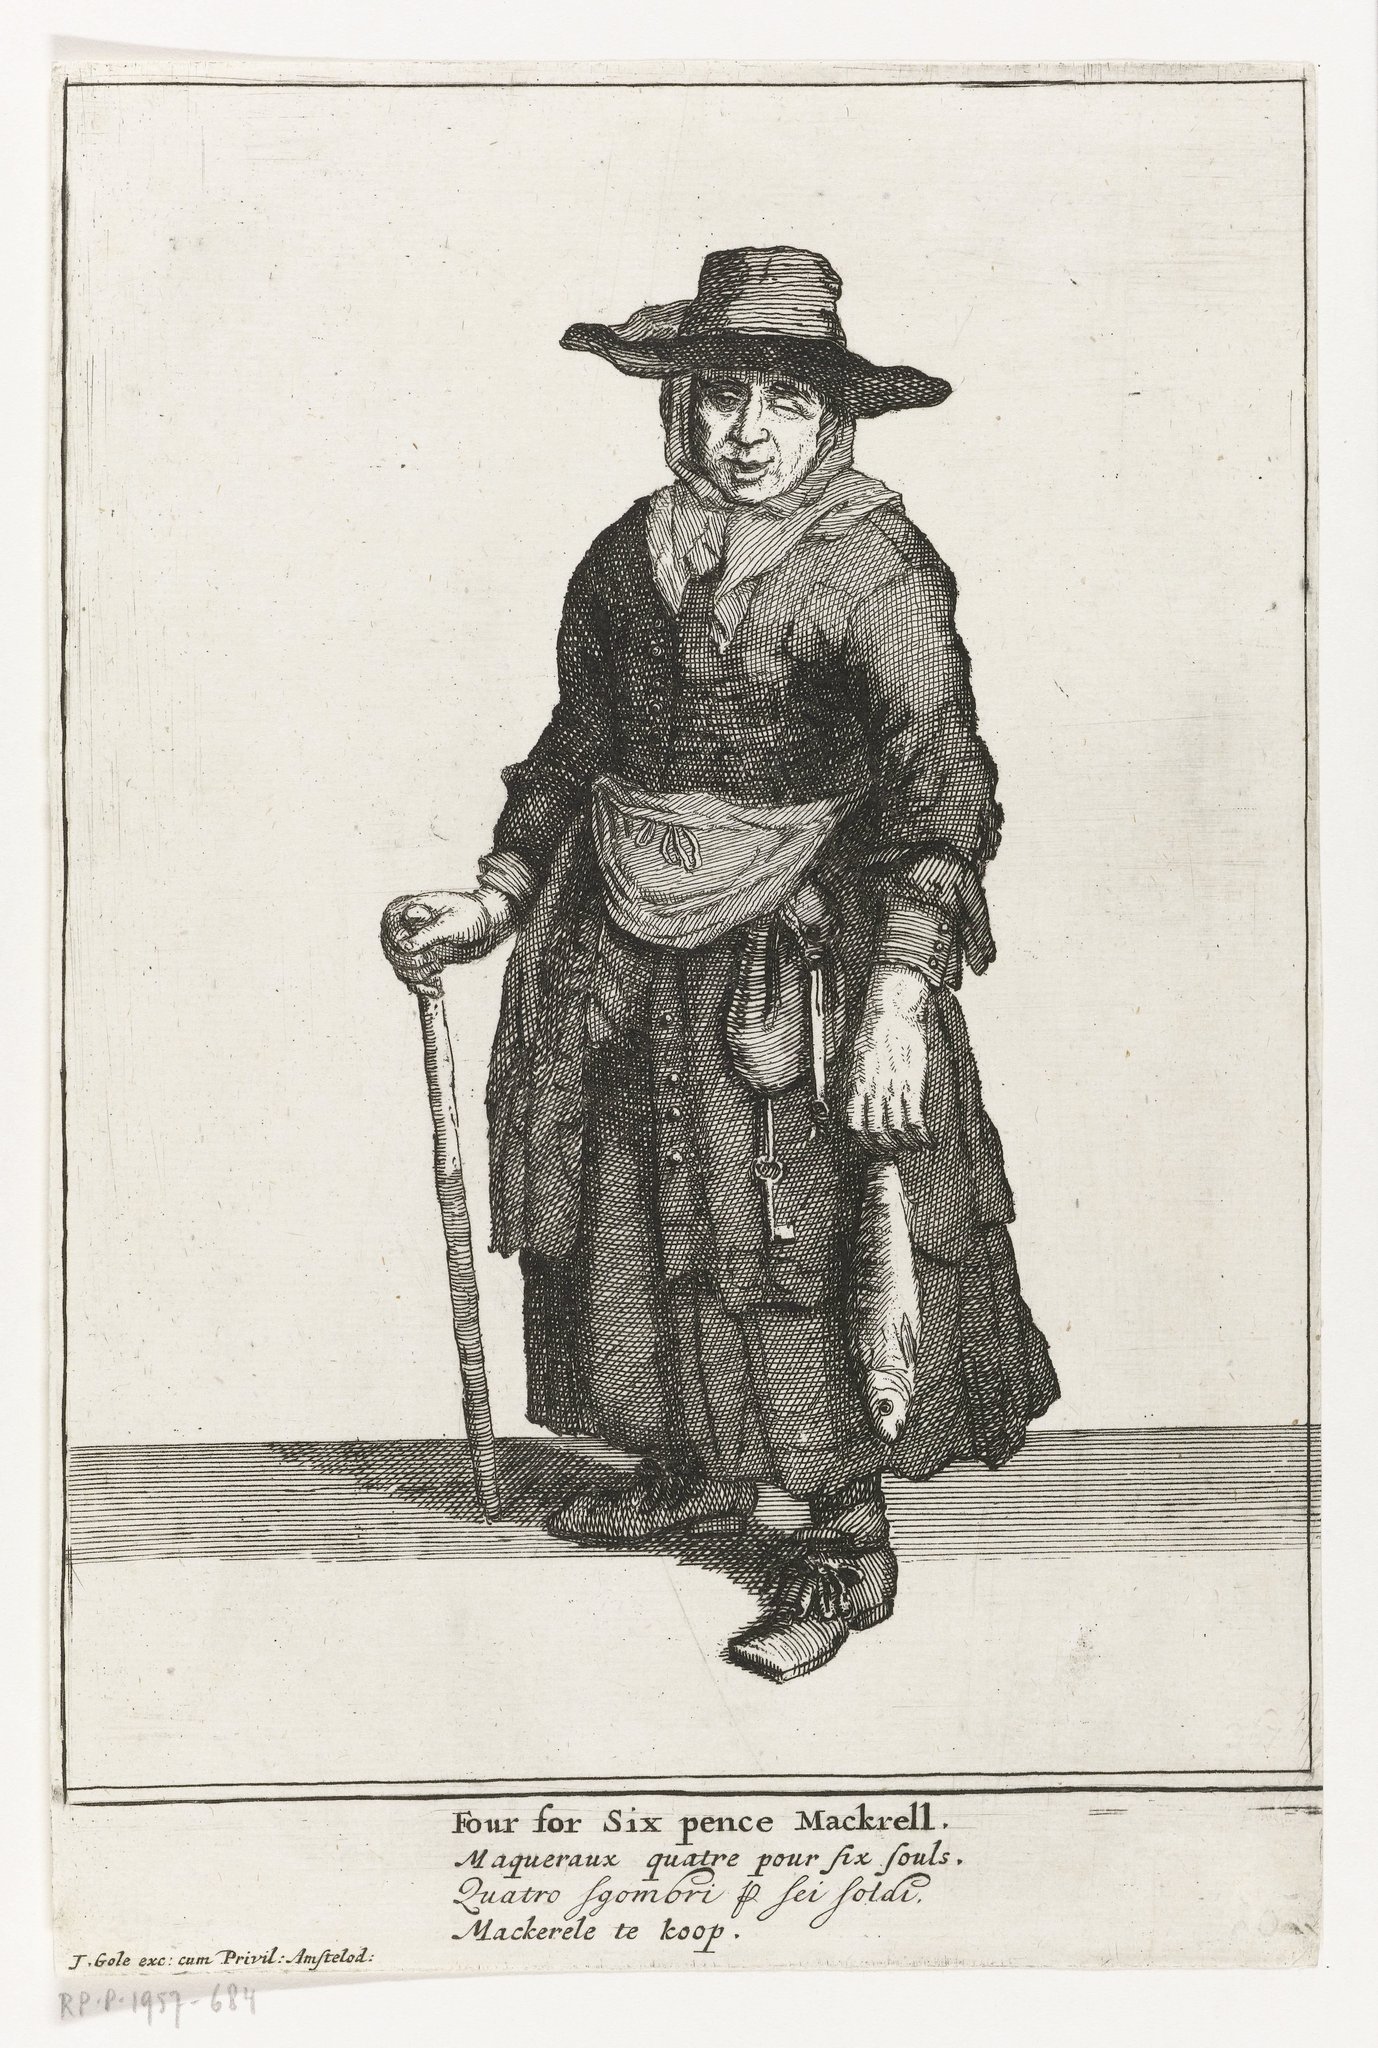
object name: print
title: Straatventers in Londen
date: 1688-1724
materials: paper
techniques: engraving, etching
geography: amsterdam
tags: ugly old woman, hag, bony fishes: mackerel, 'cris de paris', cries of london, etc. - bb - women engaged in trade and commerce, commercial fishery (+ trade ~ crafts, industries, agriculture)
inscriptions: collector's mark: Lugt 2228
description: Een oude vrouw met een wandelstok. In haar linkerhand een vis. Zij verkoopt makreel. De prent heeft een Engels, Frans, Italiaans en Nederlands onderschrift en maakt deel uit van een serie over de straatventers in Londen.